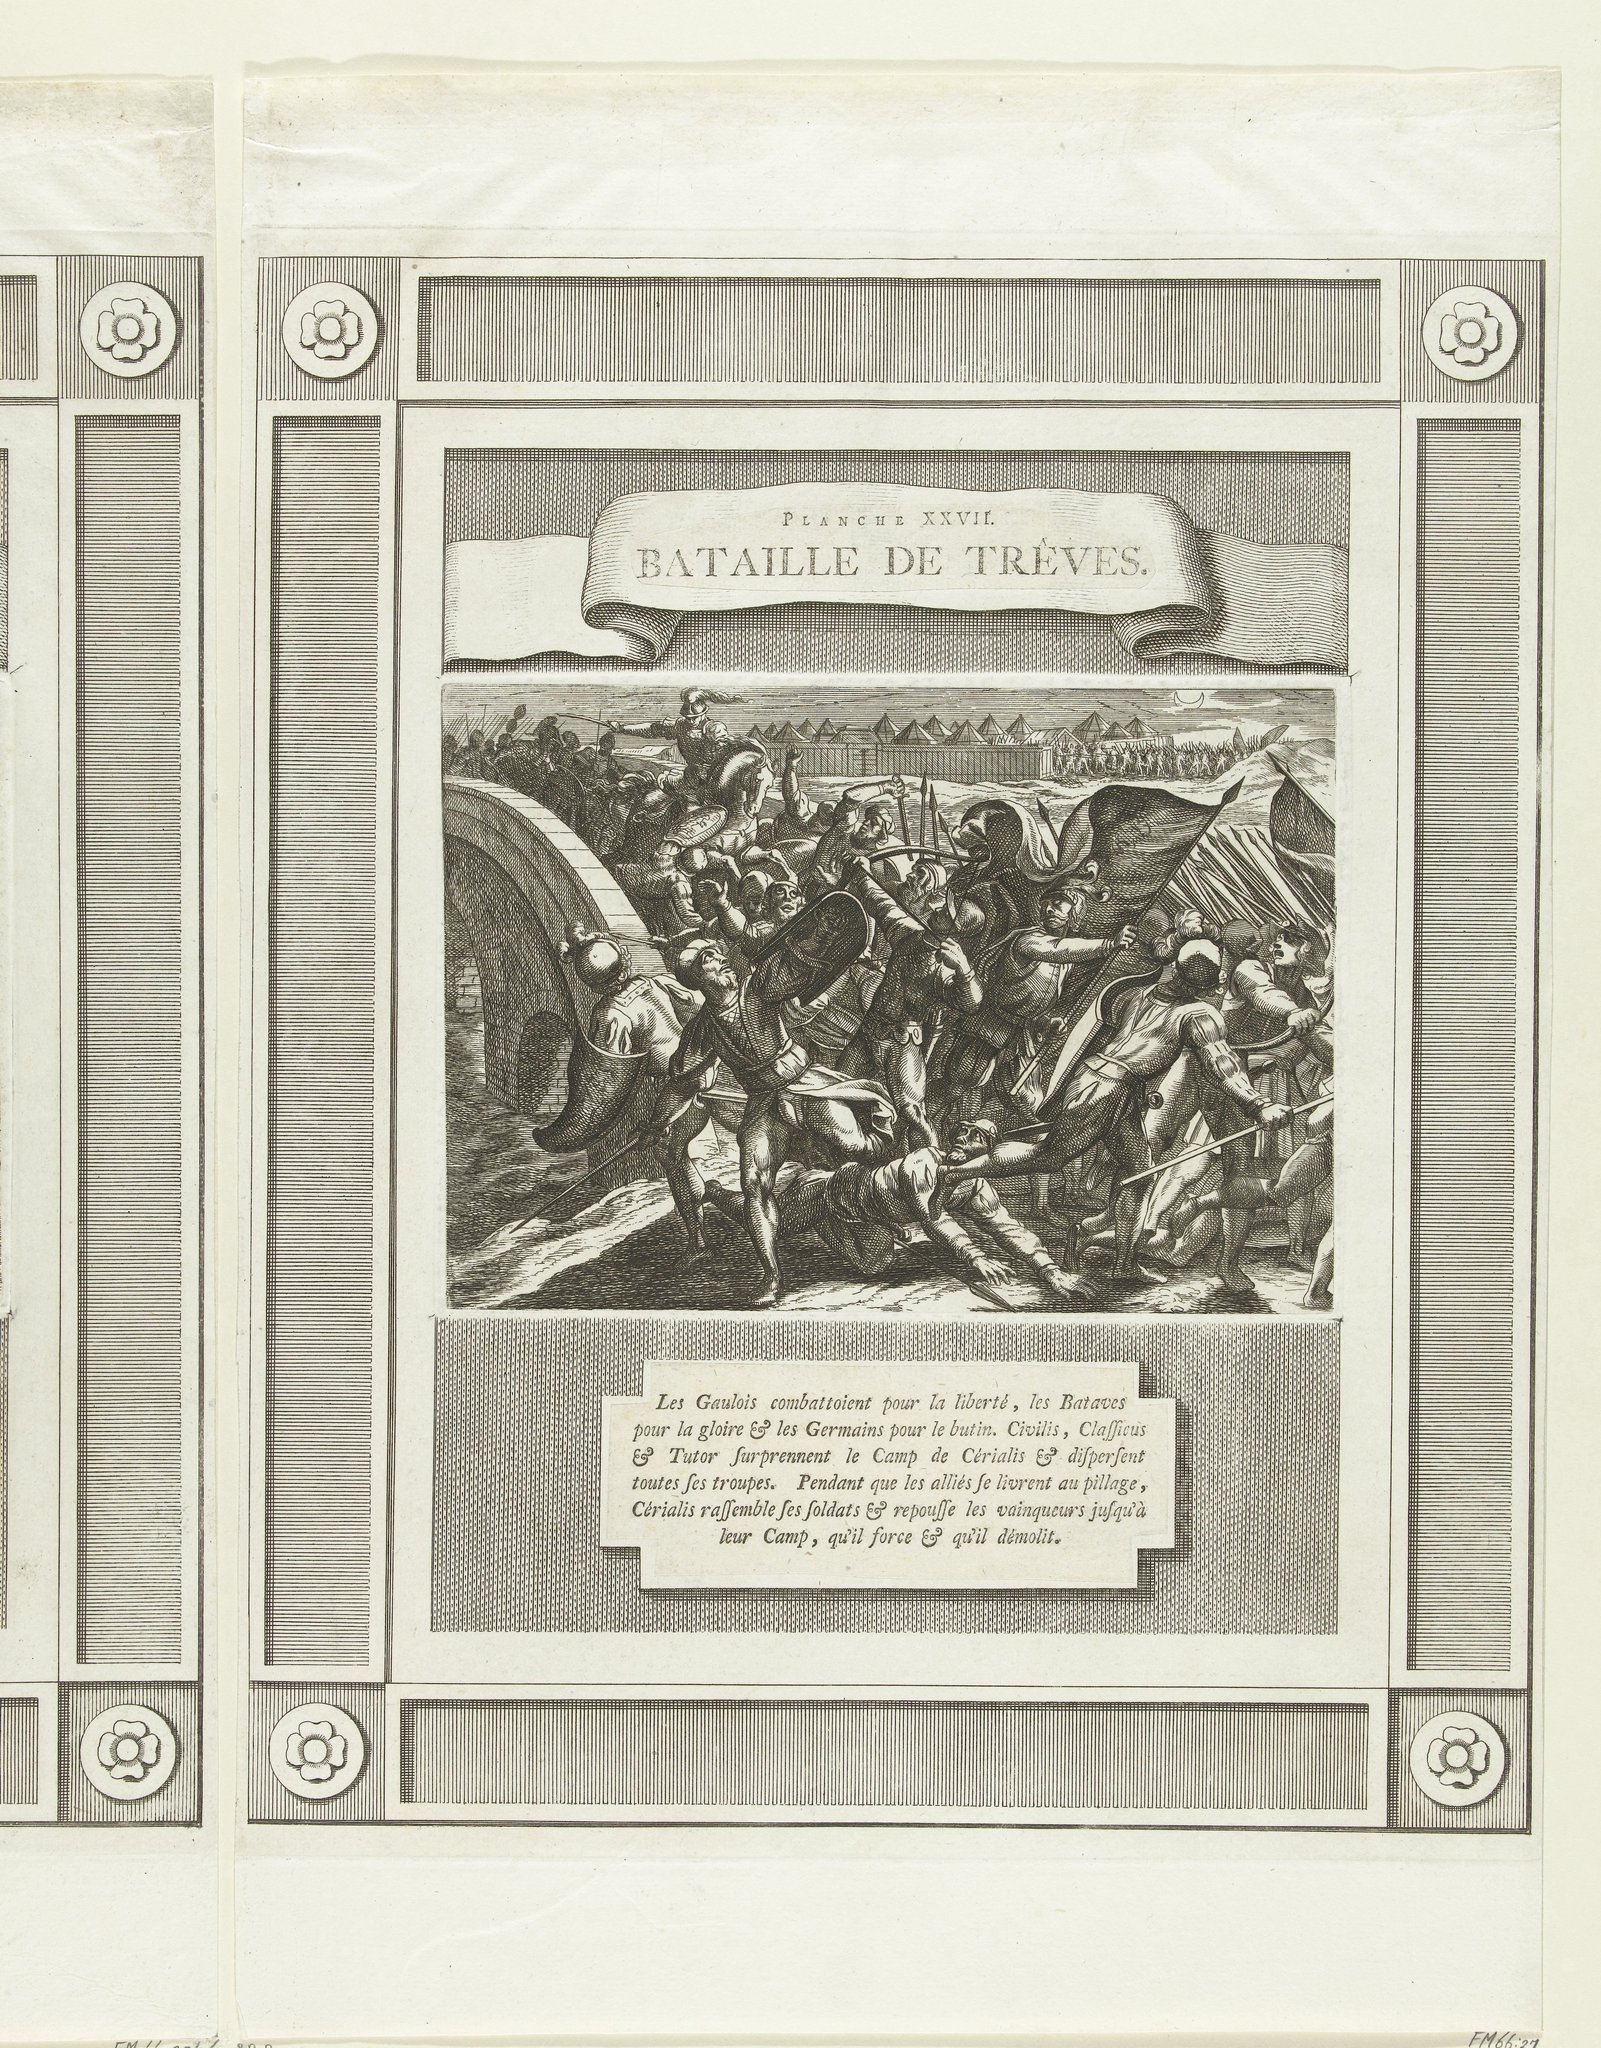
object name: history print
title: Romeinen verslagen bij een verrassingsaanval op hun kamp aan de Moezel, 69-70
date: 1768-1770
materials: paper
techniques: engraving, etching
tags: battle, fighting in general, extinct, 'historical' peoples (with name), netherlands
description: De Romeinen worden aanvankelijk verslagen bij een verrassingsaanval op hun kamp aan de Moezel, maar slaan dezelfde dag weer terug. Prent 27 in een serie over de Bataafse Opstand, gekopieerd naar de reeks Batavorum cum Romanis bellum van Antonio Tempesta (Otto Vaenius, Antwerpen 1612). Illustratie voor: Marquis de St. Simon, Histoire de la guerre des Bataves et des Romains, d'après César; Corneille Tacite, Aux dépens de Marc-Michel Rey, Amsterdam 1770. Voorstellingen gedrukt in een grote ornamentele omlijsting waarin bovenaan een uitgeknipte titel en onderaan een onderschrift in het Frans is geplakt.